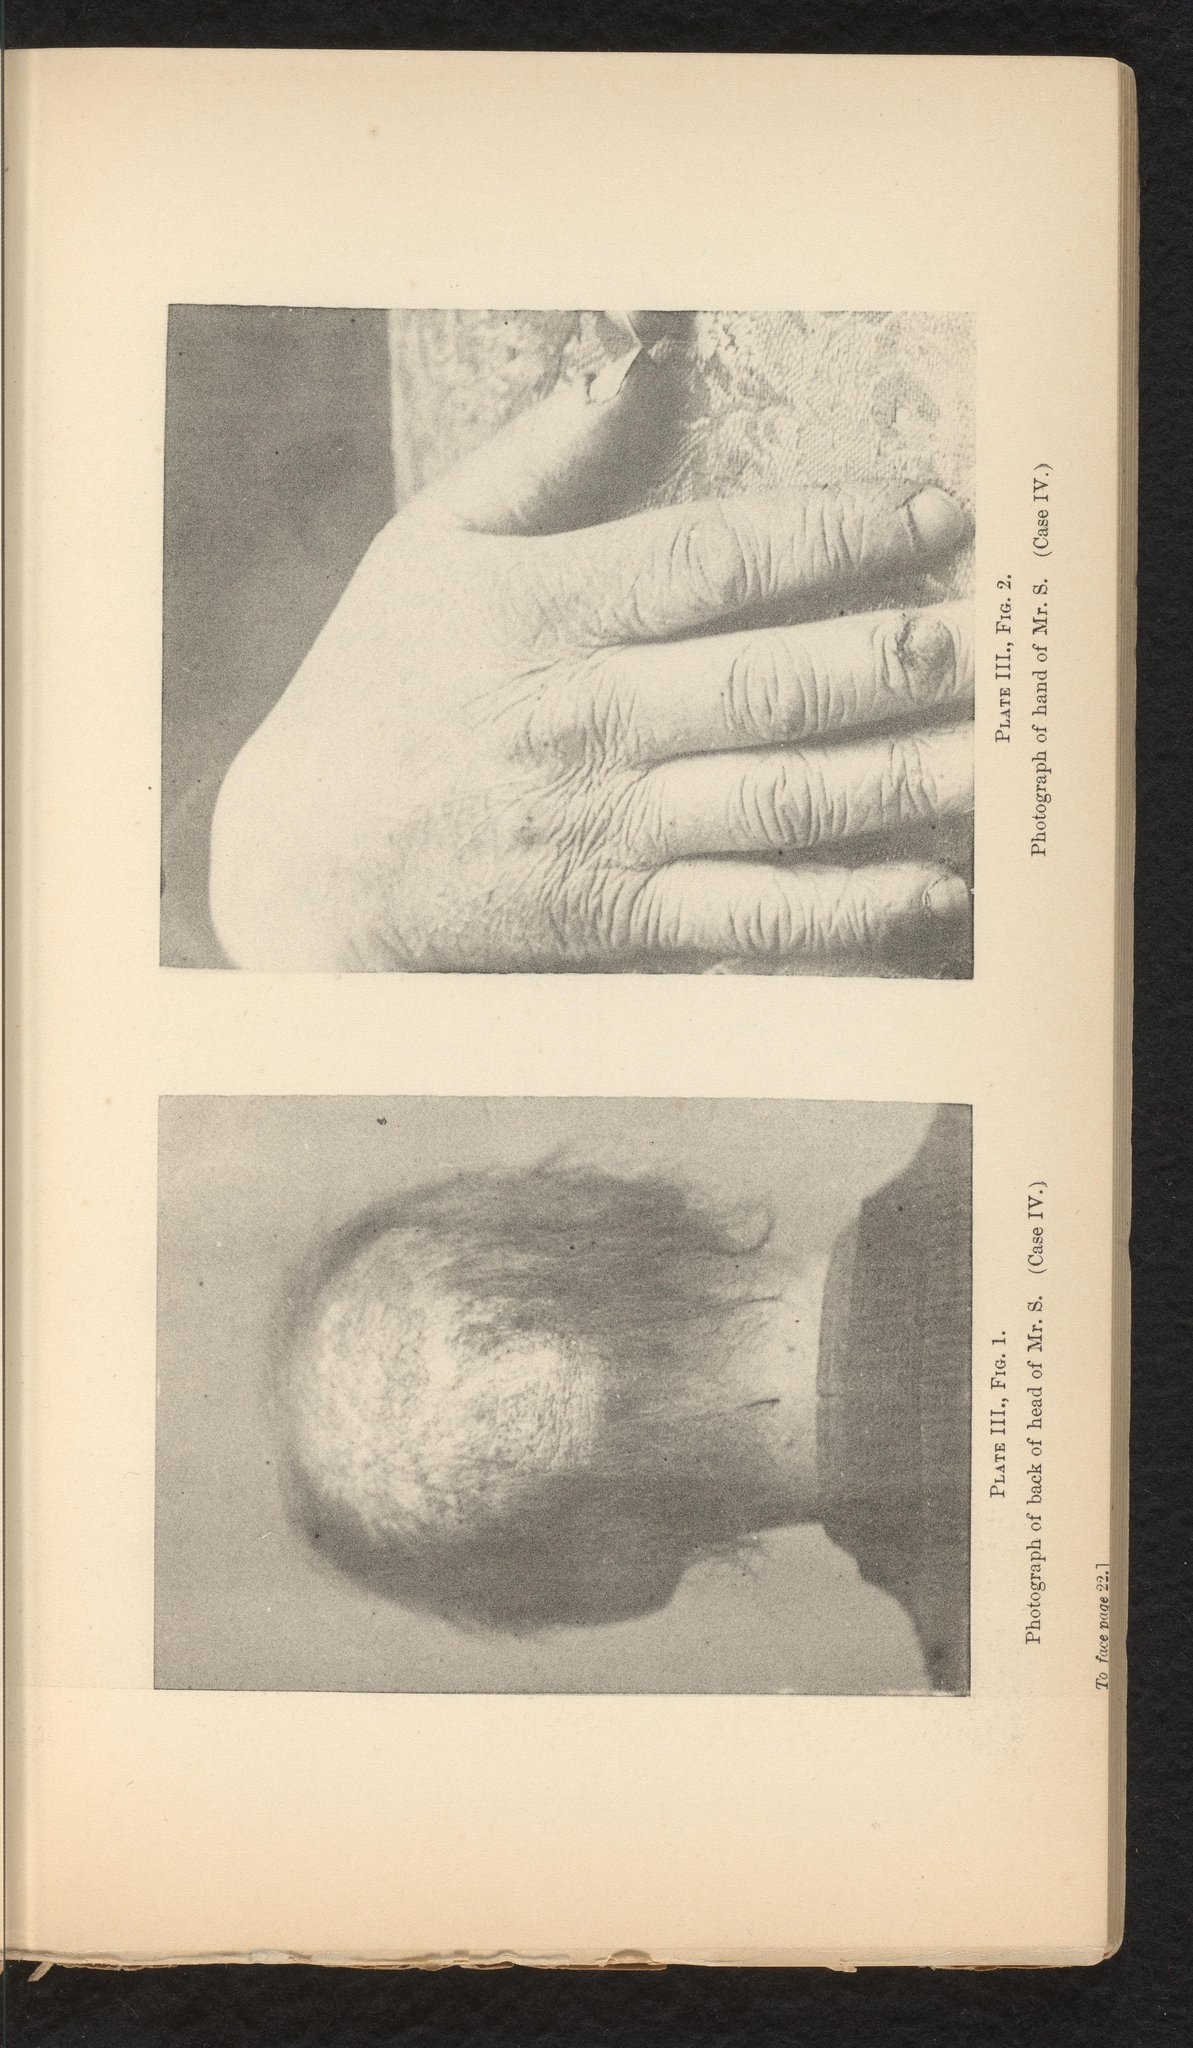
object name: page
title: Achterhoofd en hand van een onbekende man ter illustratie van myxoedeem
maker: Anonymous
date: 1883-1888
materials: linen, paper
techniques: photograph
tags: hand, historical persons, diseases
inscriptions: inscription: ‘Plate III., Fig. 1./ Photograph of back of head of Mr. S. (Case IV.)’, inscription: ‘Plate III., Fig. 2./ Photograph of had of Mr. S. (Case IV.)’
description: Prent op derde ongenummerde pagina na pagina 22.